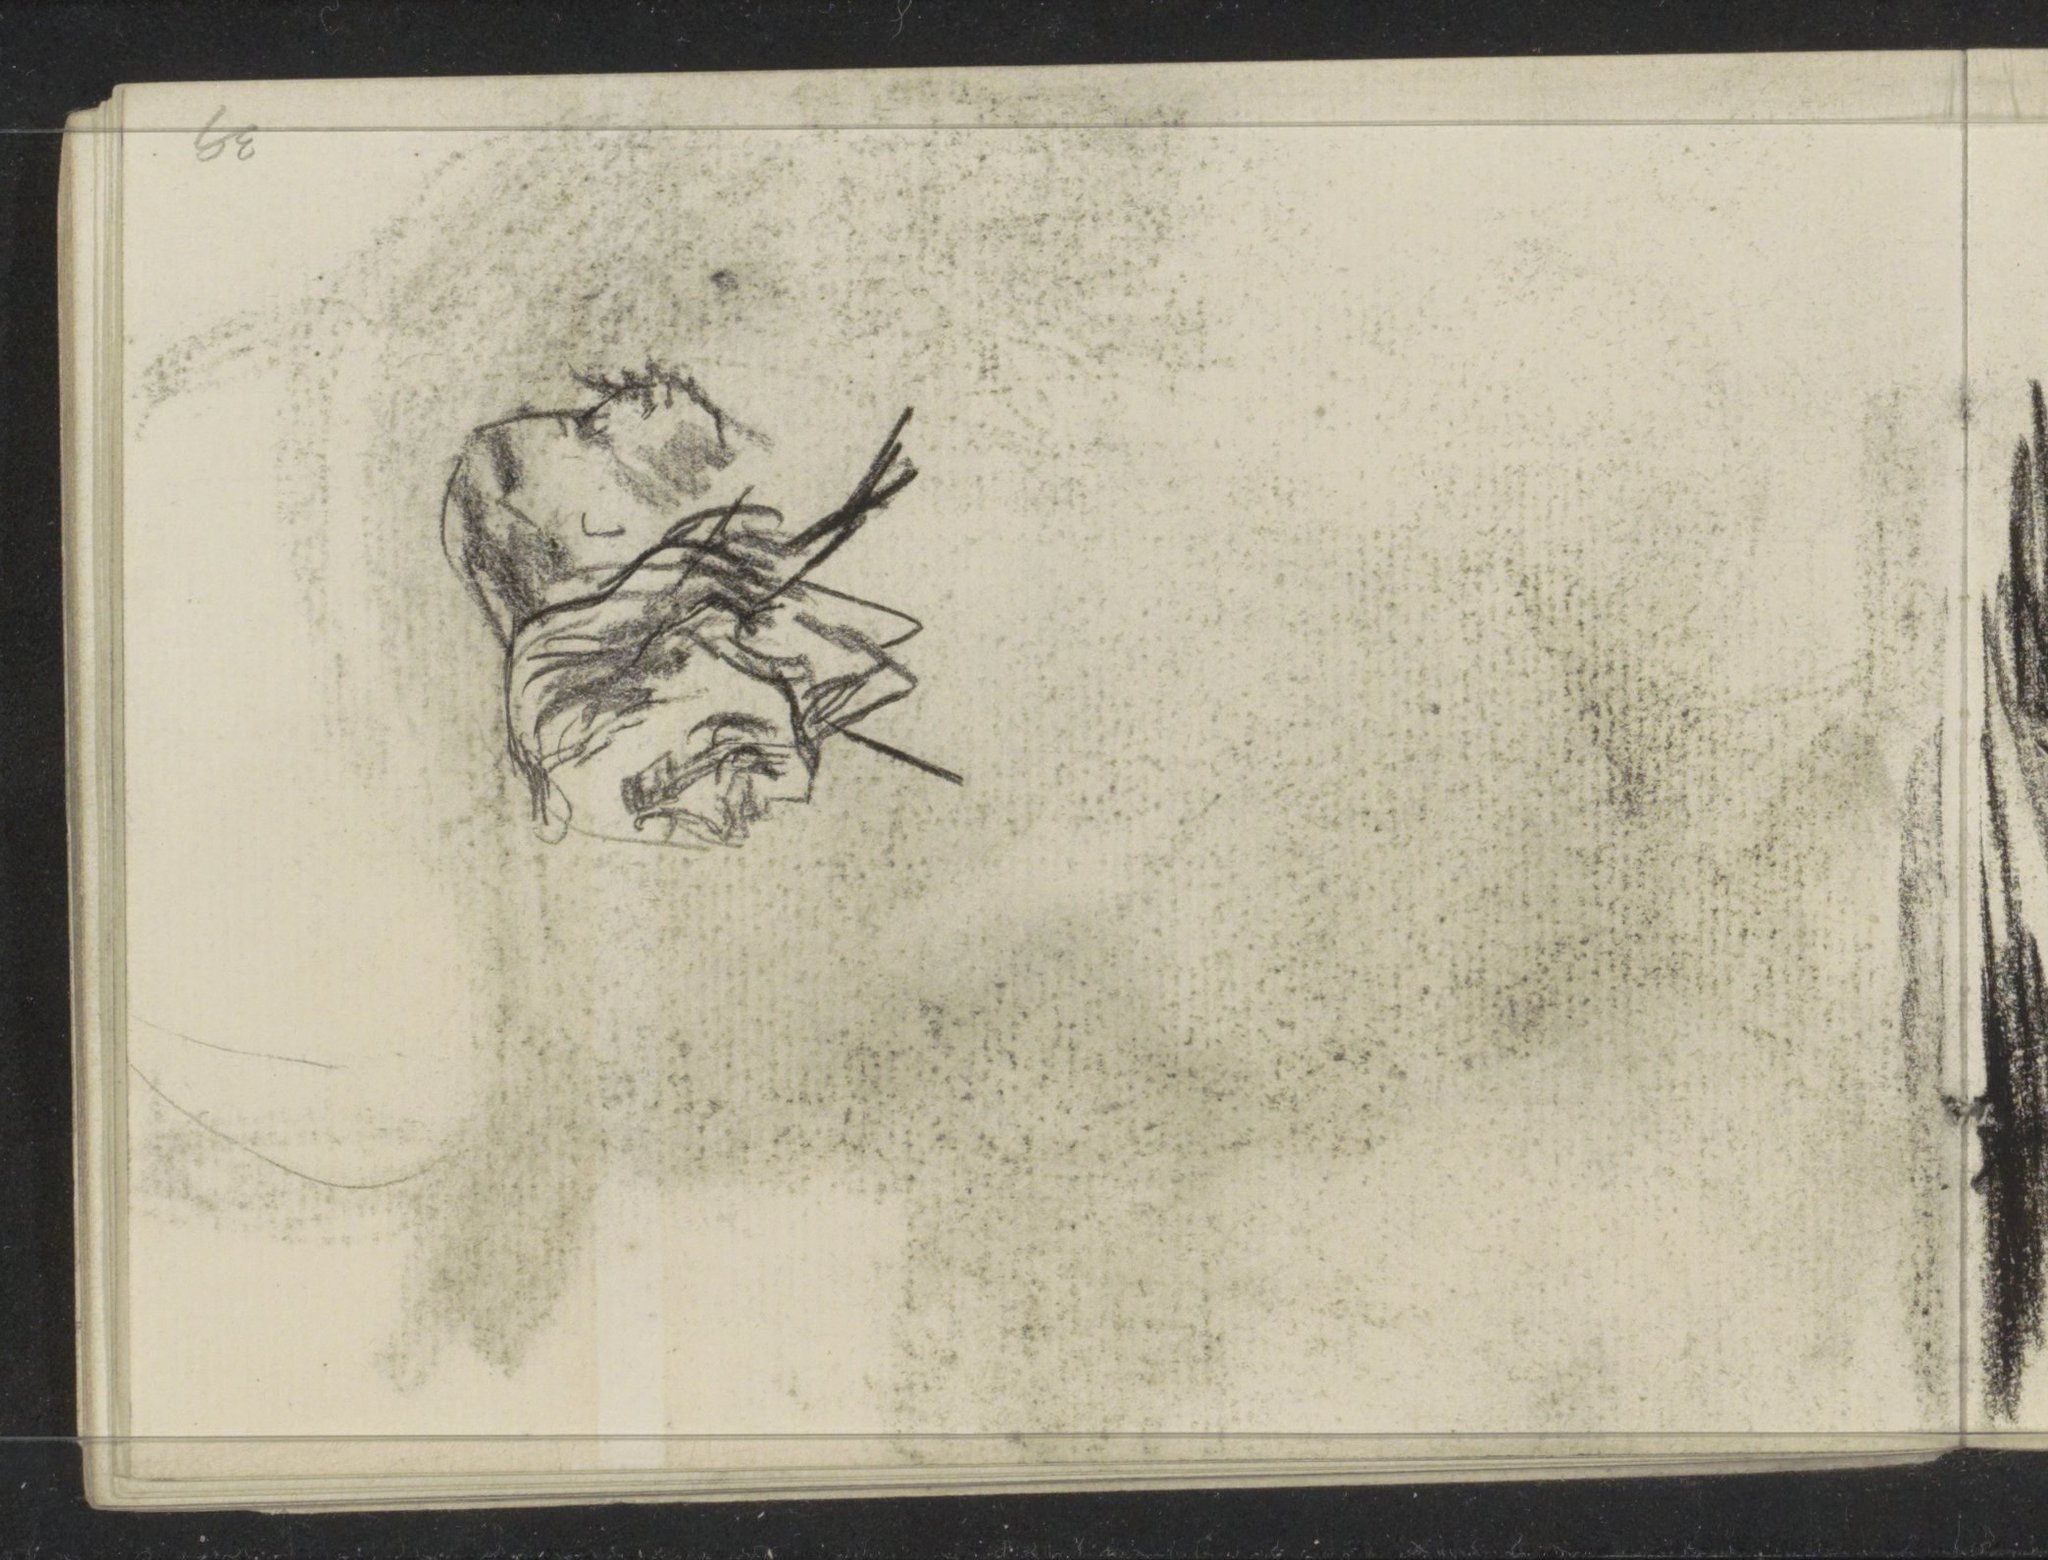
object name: sketchbook leaf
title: Twee hoofden, in profiel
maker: isaac israels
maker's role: draughtsman, painter, print maker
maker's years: 1865-1934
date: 1886-1934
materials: chalk, paper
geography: amsterdam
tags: head (human) (+ sideview, profile)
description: Blad 20 verso uit schetsboek LXIV met 29 bladen.